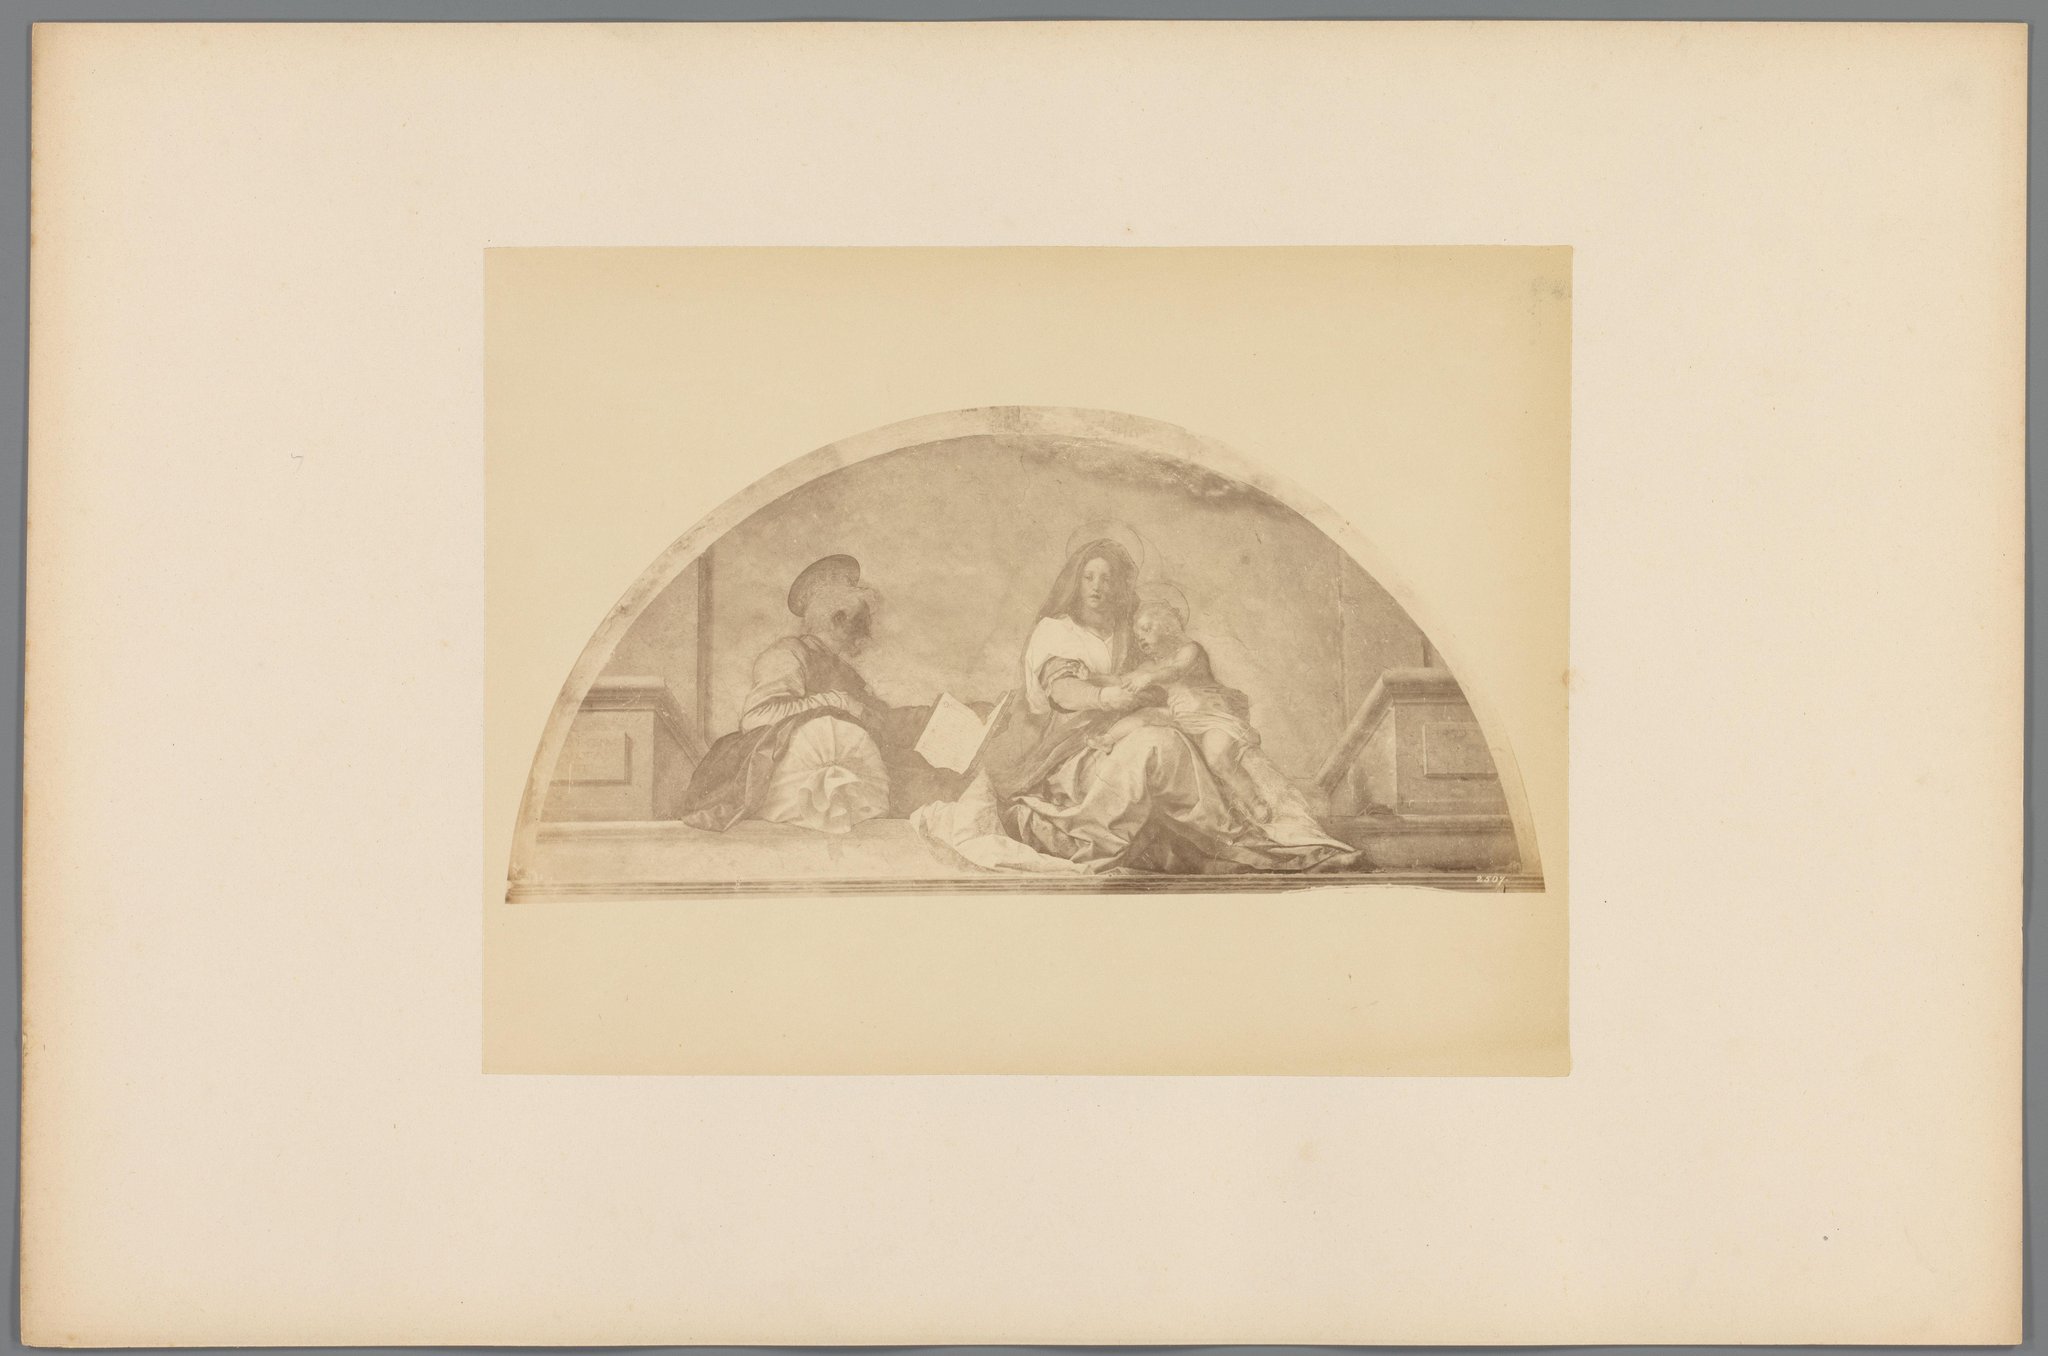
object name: reproduction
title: Fotoreproductie van een fresco voorstellende Maria en Christus en een heilige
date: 1857-1900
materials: cardboard, paper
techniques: albumen print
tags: madonna (i.e. mary with the christ-child) accompanied or surrounded by others, wall-covering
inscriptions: number: ‘2507.’